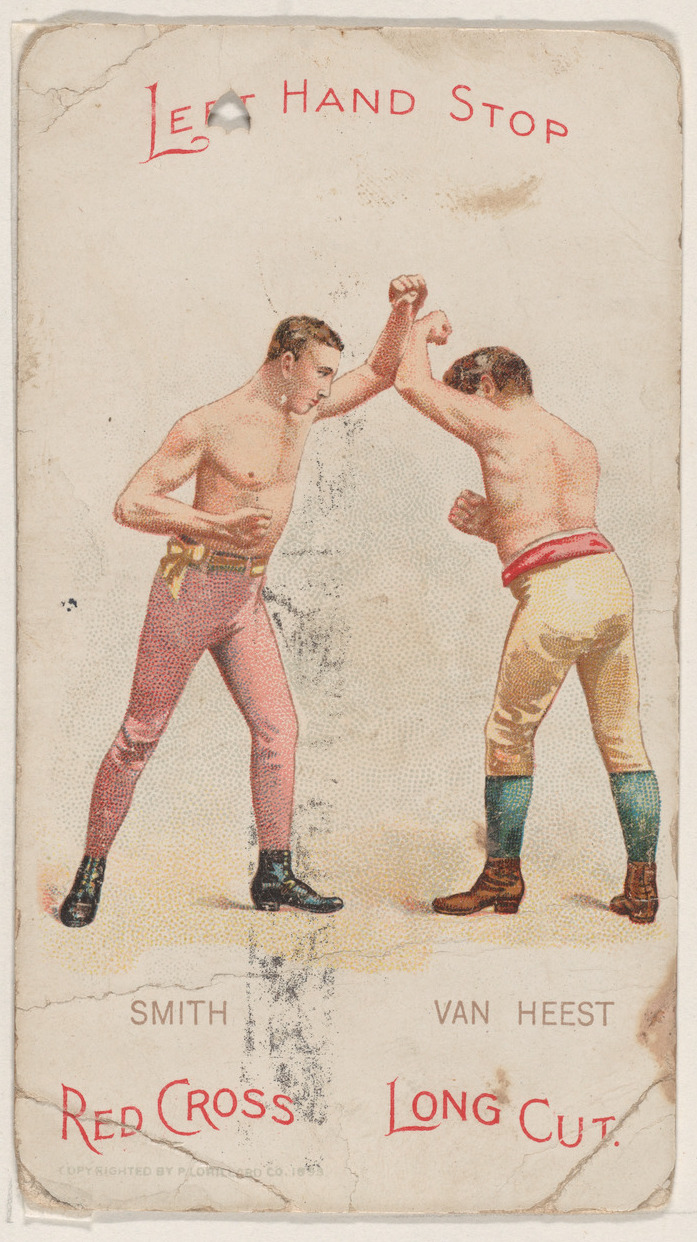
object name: print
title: Left Hand Stop, Solomon Smith and Johnny Van Heest, from the Boxing Positions and Boxers series (N266) issued by P. Lorillard Company to promote Red Cross Long Cut Tobacco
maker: p. lorillard company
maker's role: publisher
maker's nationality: american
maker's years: 1760-2014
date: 1893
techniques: color lithograph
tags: men,boxing,athletes